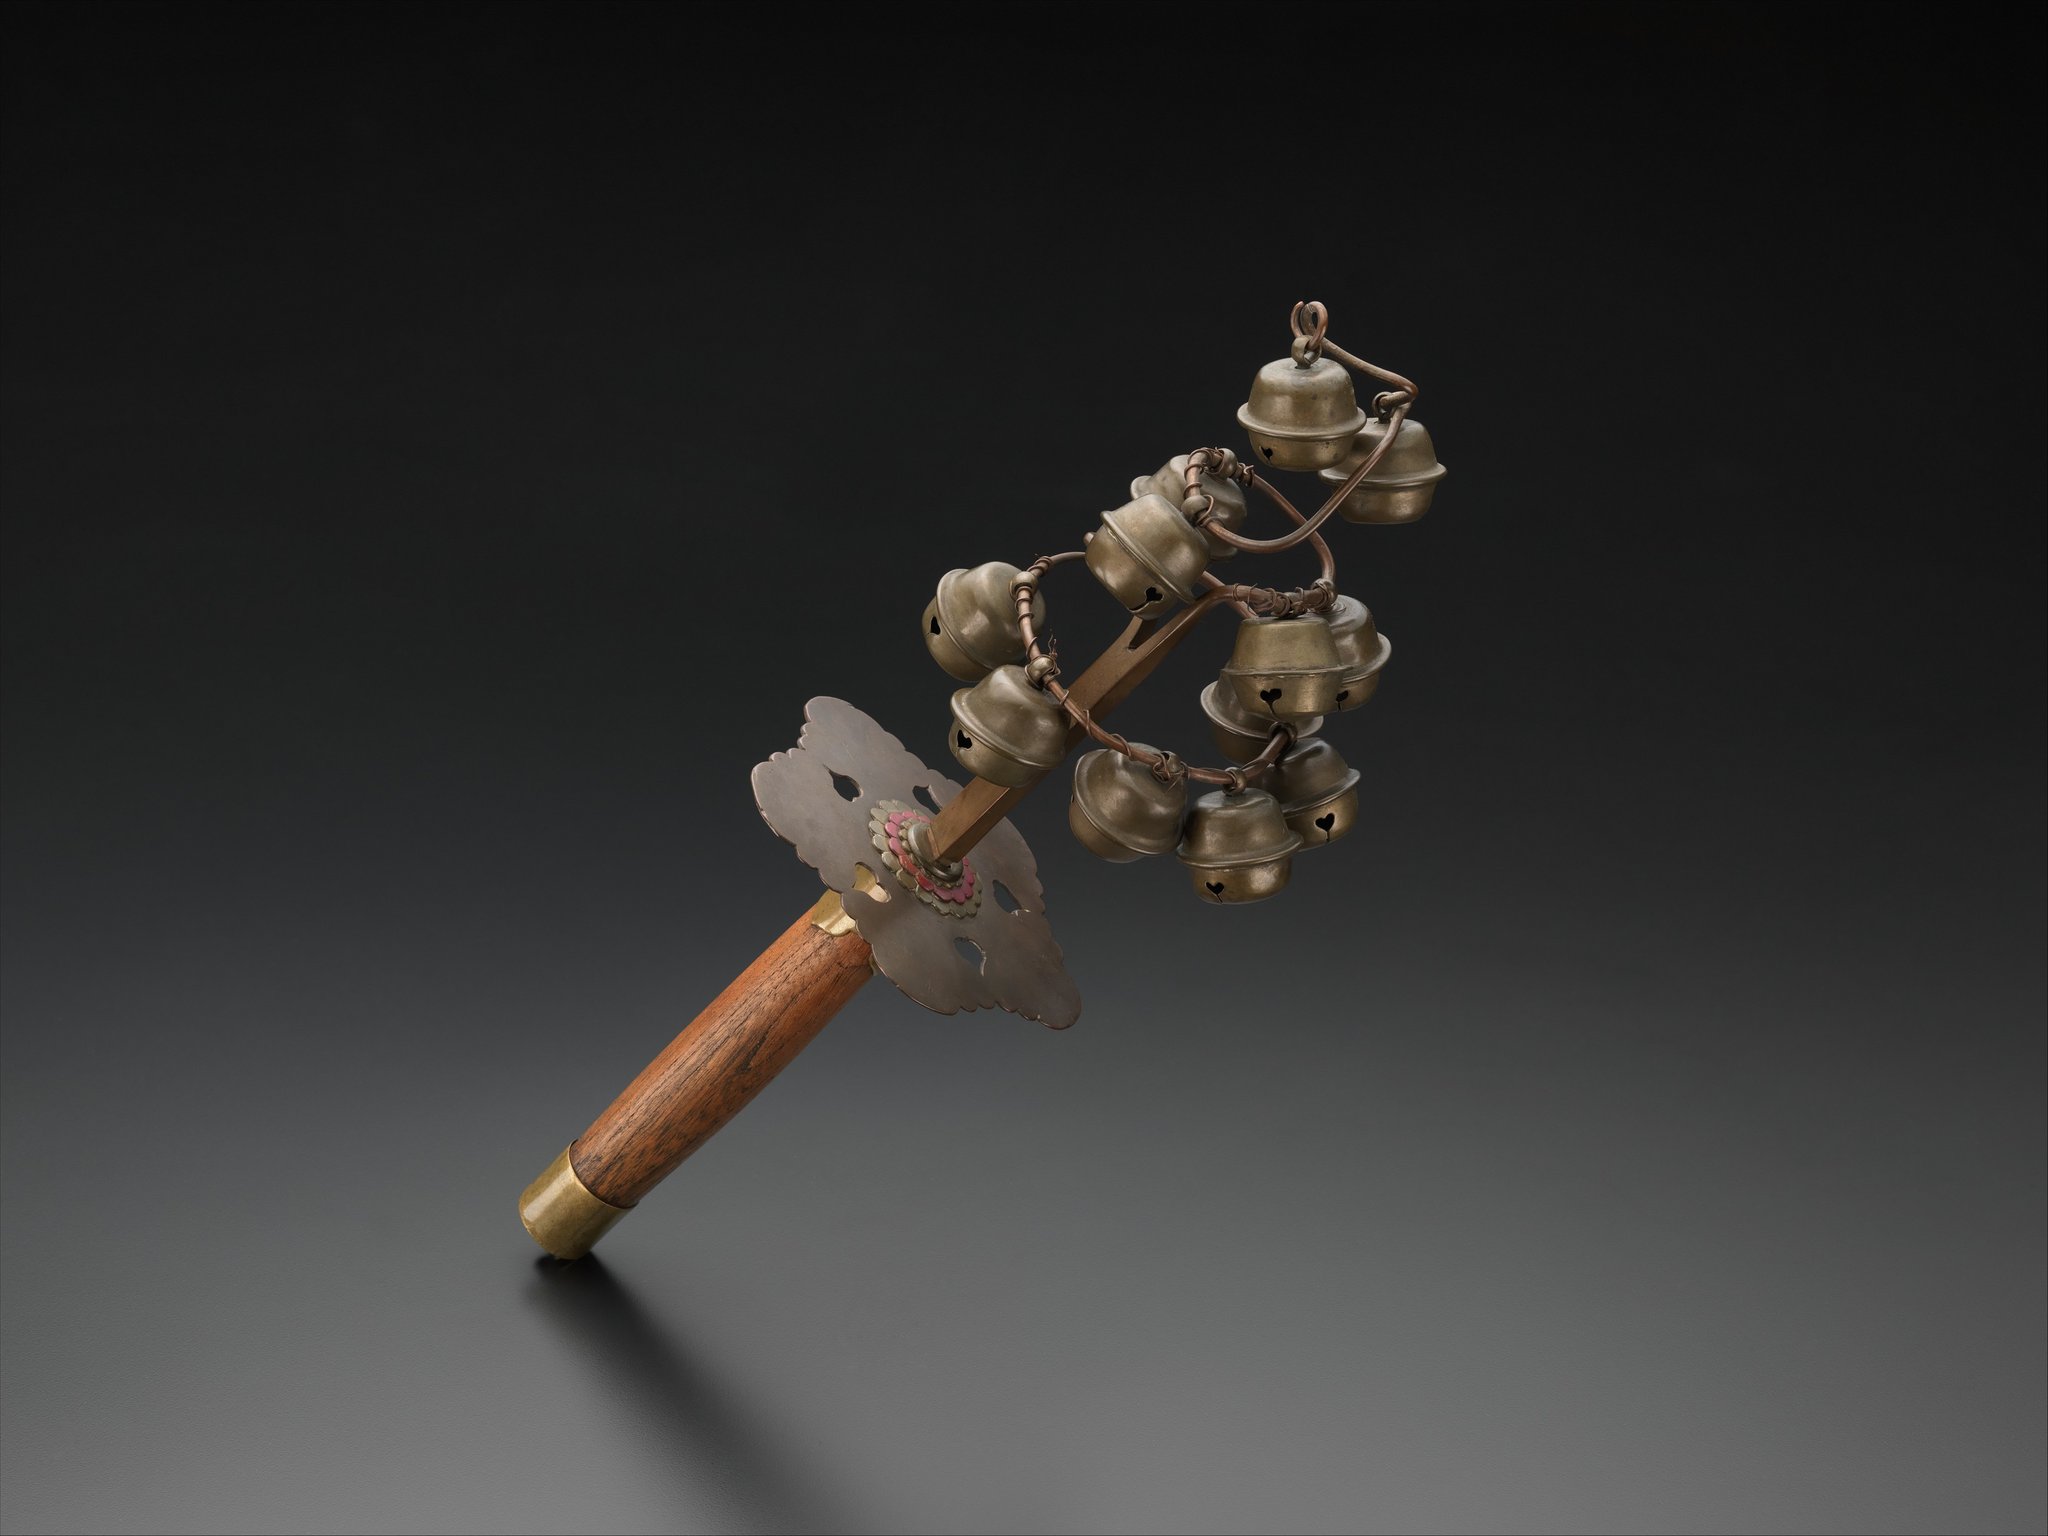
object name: suzu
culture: japanese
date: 1601-1700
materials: metal, wood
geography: japan